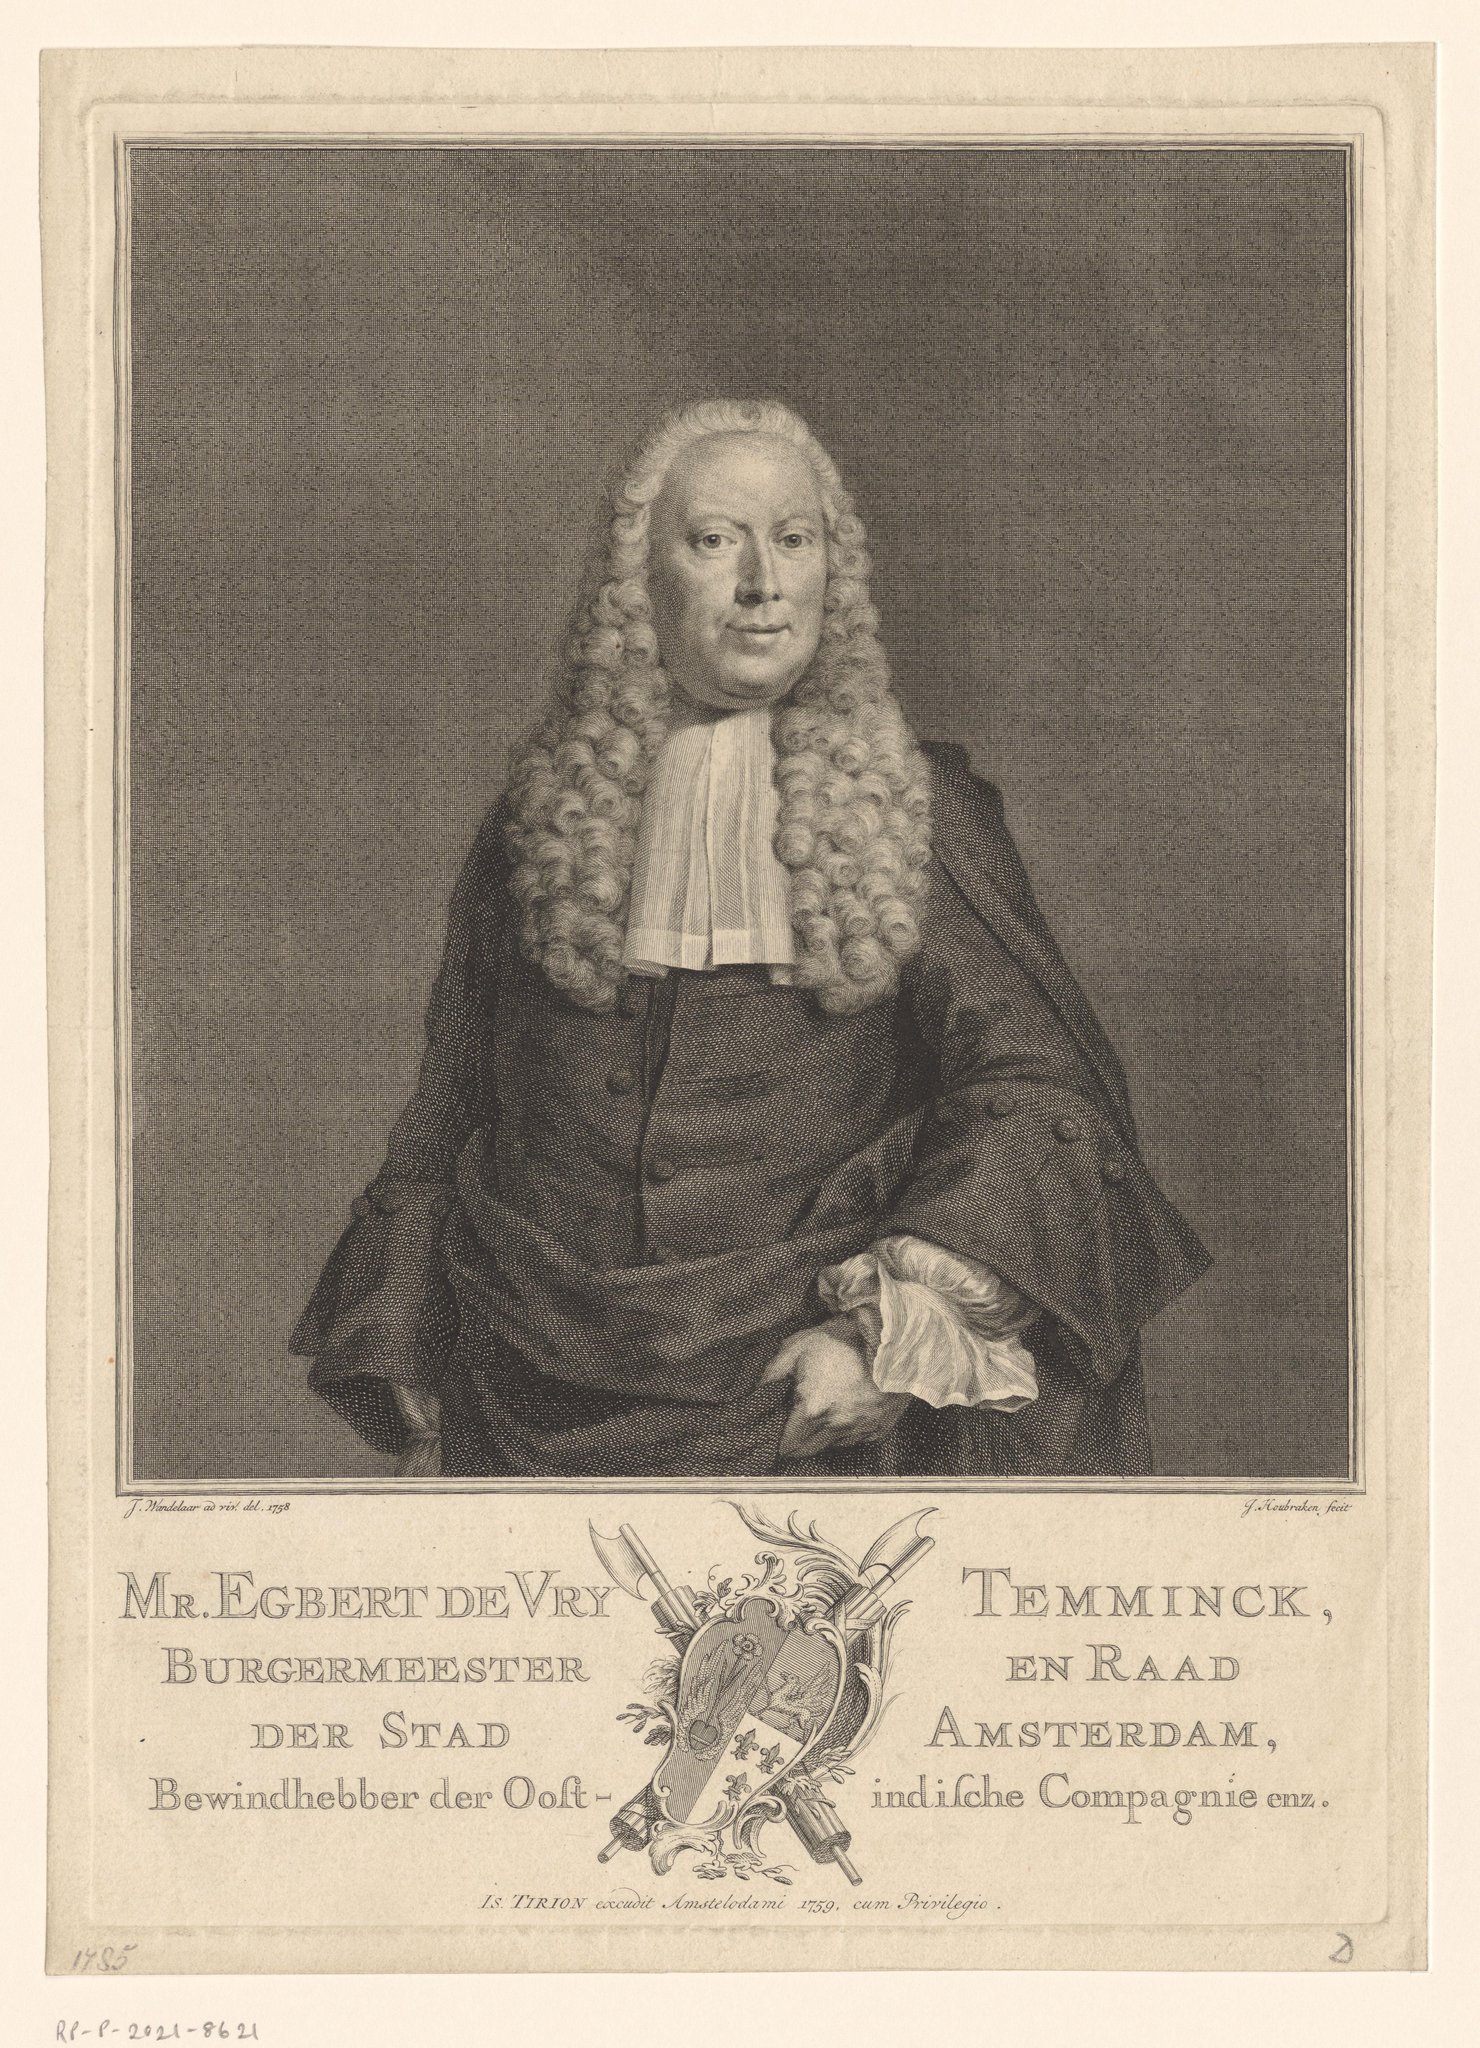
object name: print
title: Portret van Egbert de Vrij Temminck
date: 1759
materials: paper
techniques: engraving, etching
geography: amsterdam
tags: amsterdam, egbert de vrij temminck, mayor, burgomaster, historical persons, armorial bearing, heraldry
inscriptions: date